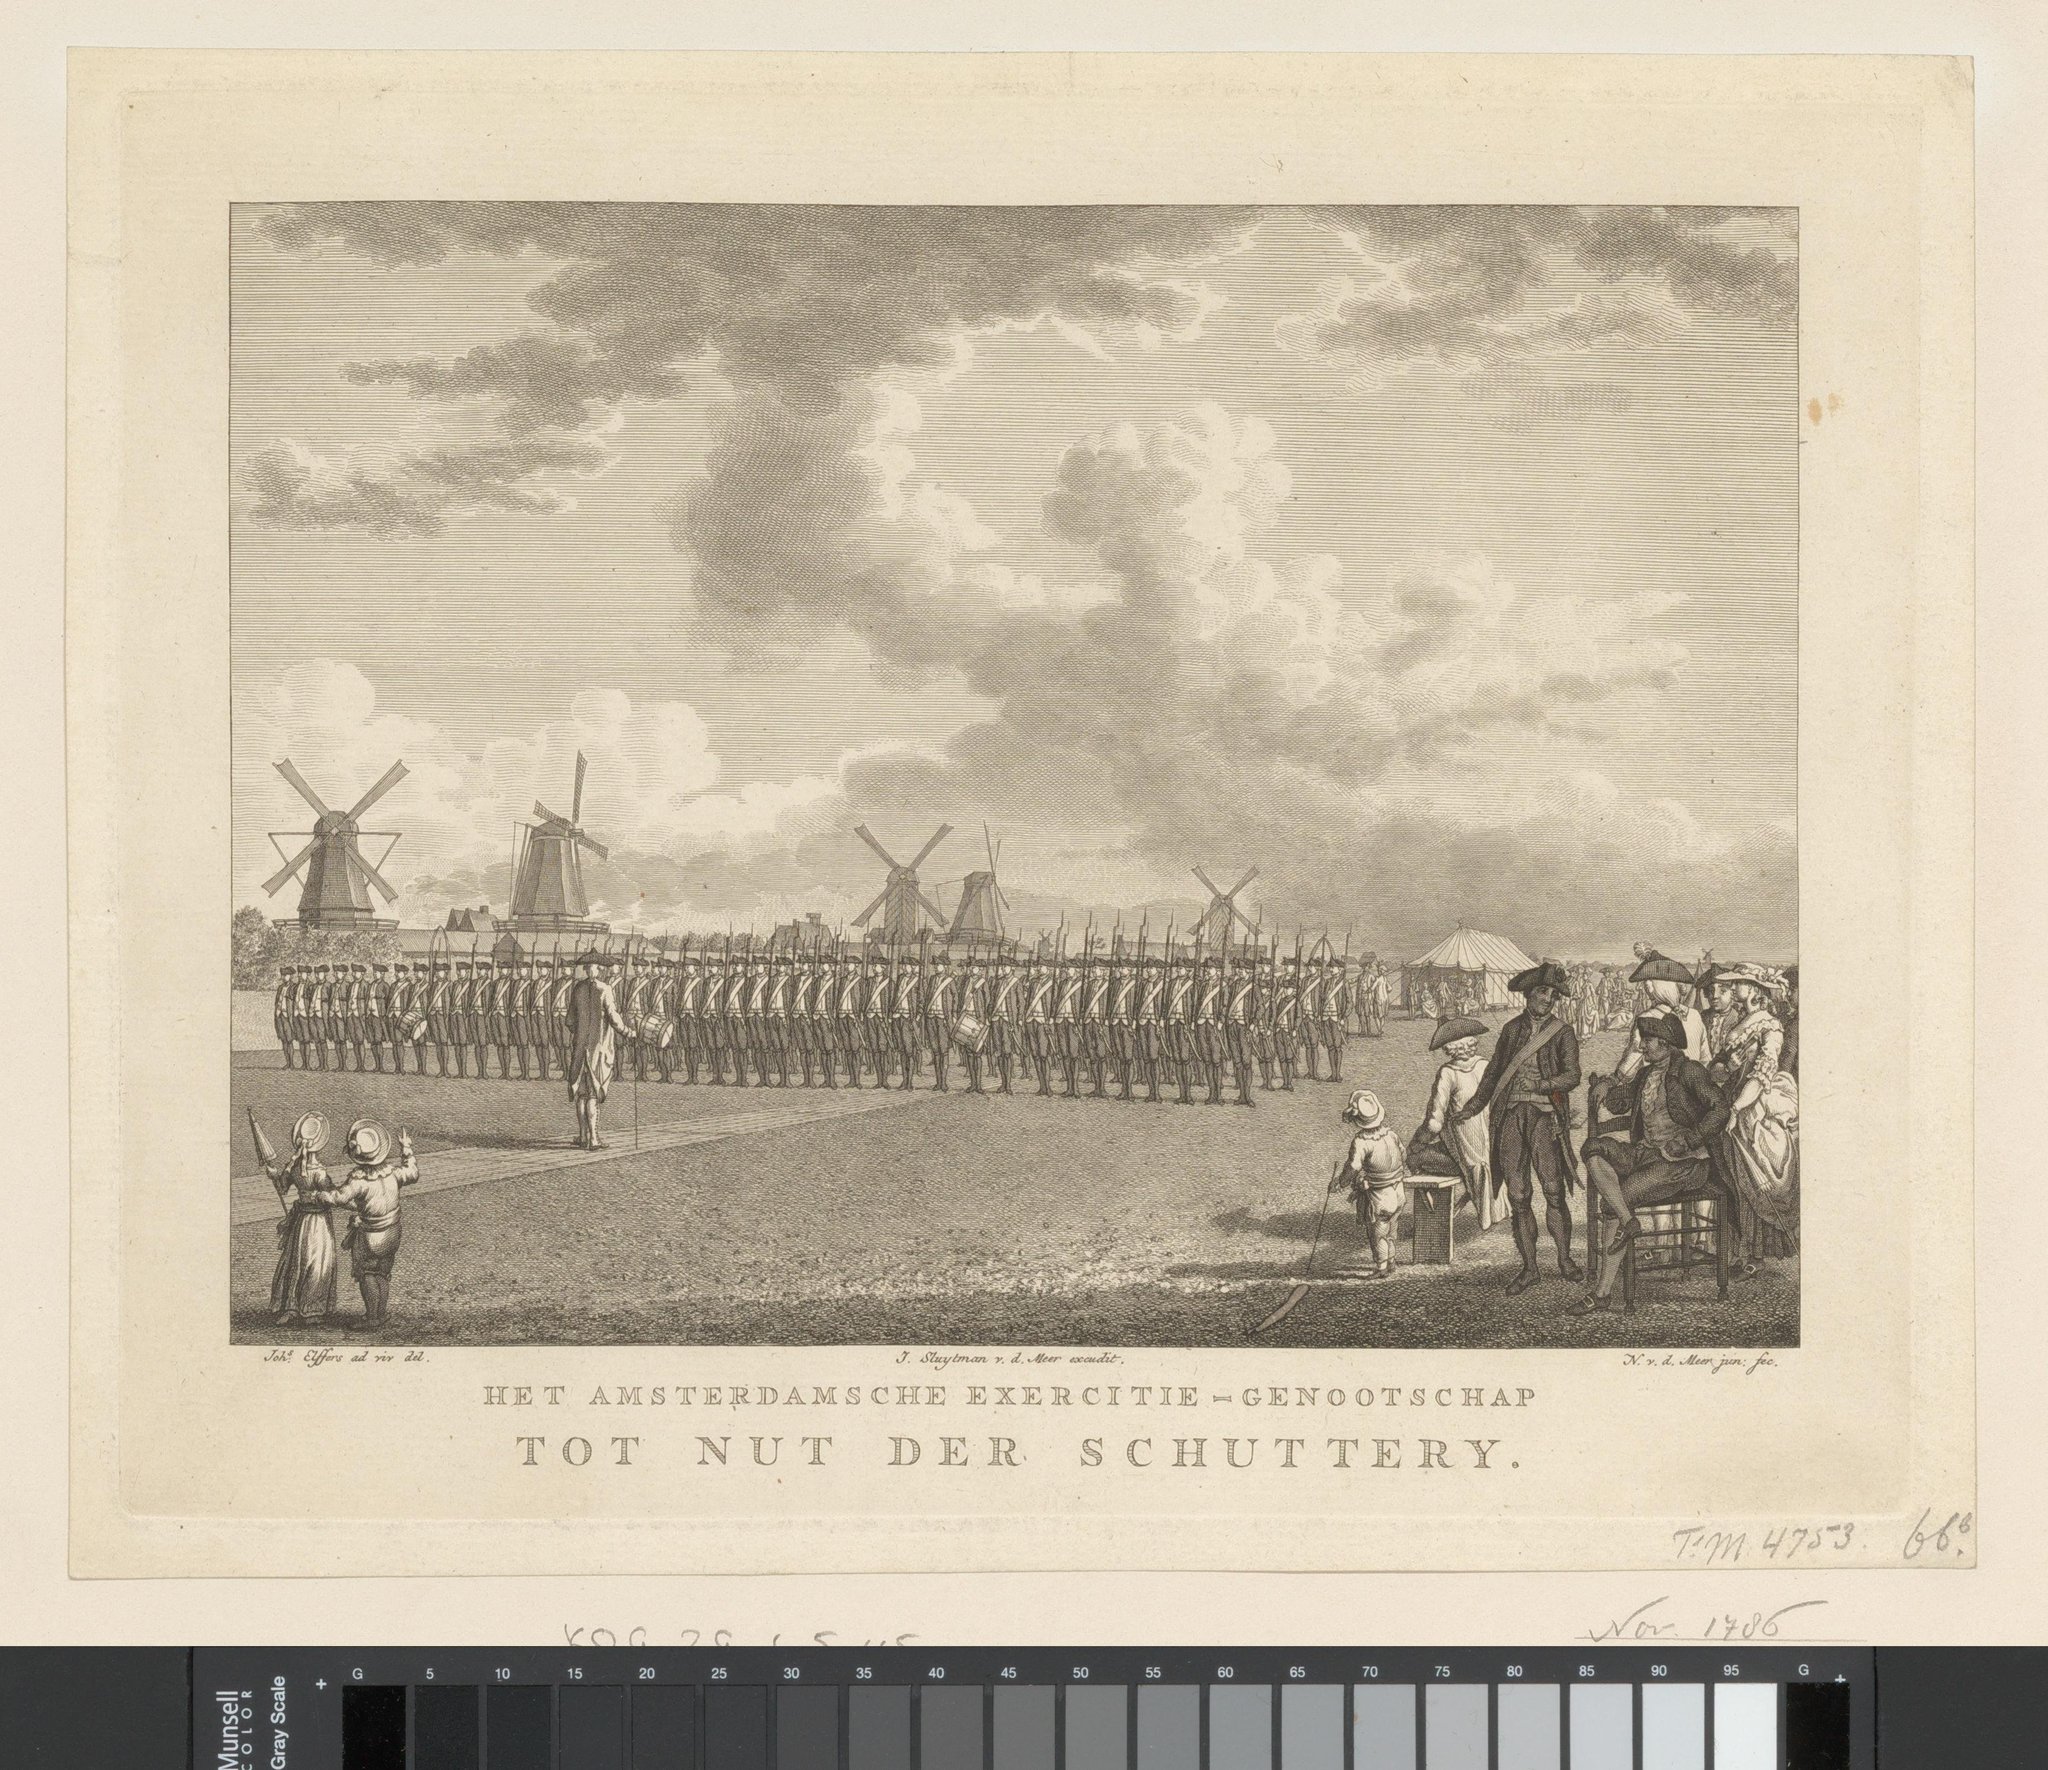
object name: print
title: Oefening van het Amsterdamse exercitiegenootschap Tot Nut der Schuttery, 1786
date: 1786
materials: paper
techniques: engraving, etching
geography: amsterdam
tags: military demonstrations, amsterdam, patriots (1780-1795)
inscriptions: stamp, collector's mark: Lugt 1641, stamp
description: Oefening van het Amsterdamse exercitiegenootschap Tot Nut der Schuttery, op een veld achter de Herberg Malta op de toenmalige Buitensingel, september 1786. Onderwerpsrubrieken binnen de Atlas Zeden en Gewoonten: Krijgswezen, Schutterij, Historieprenten.